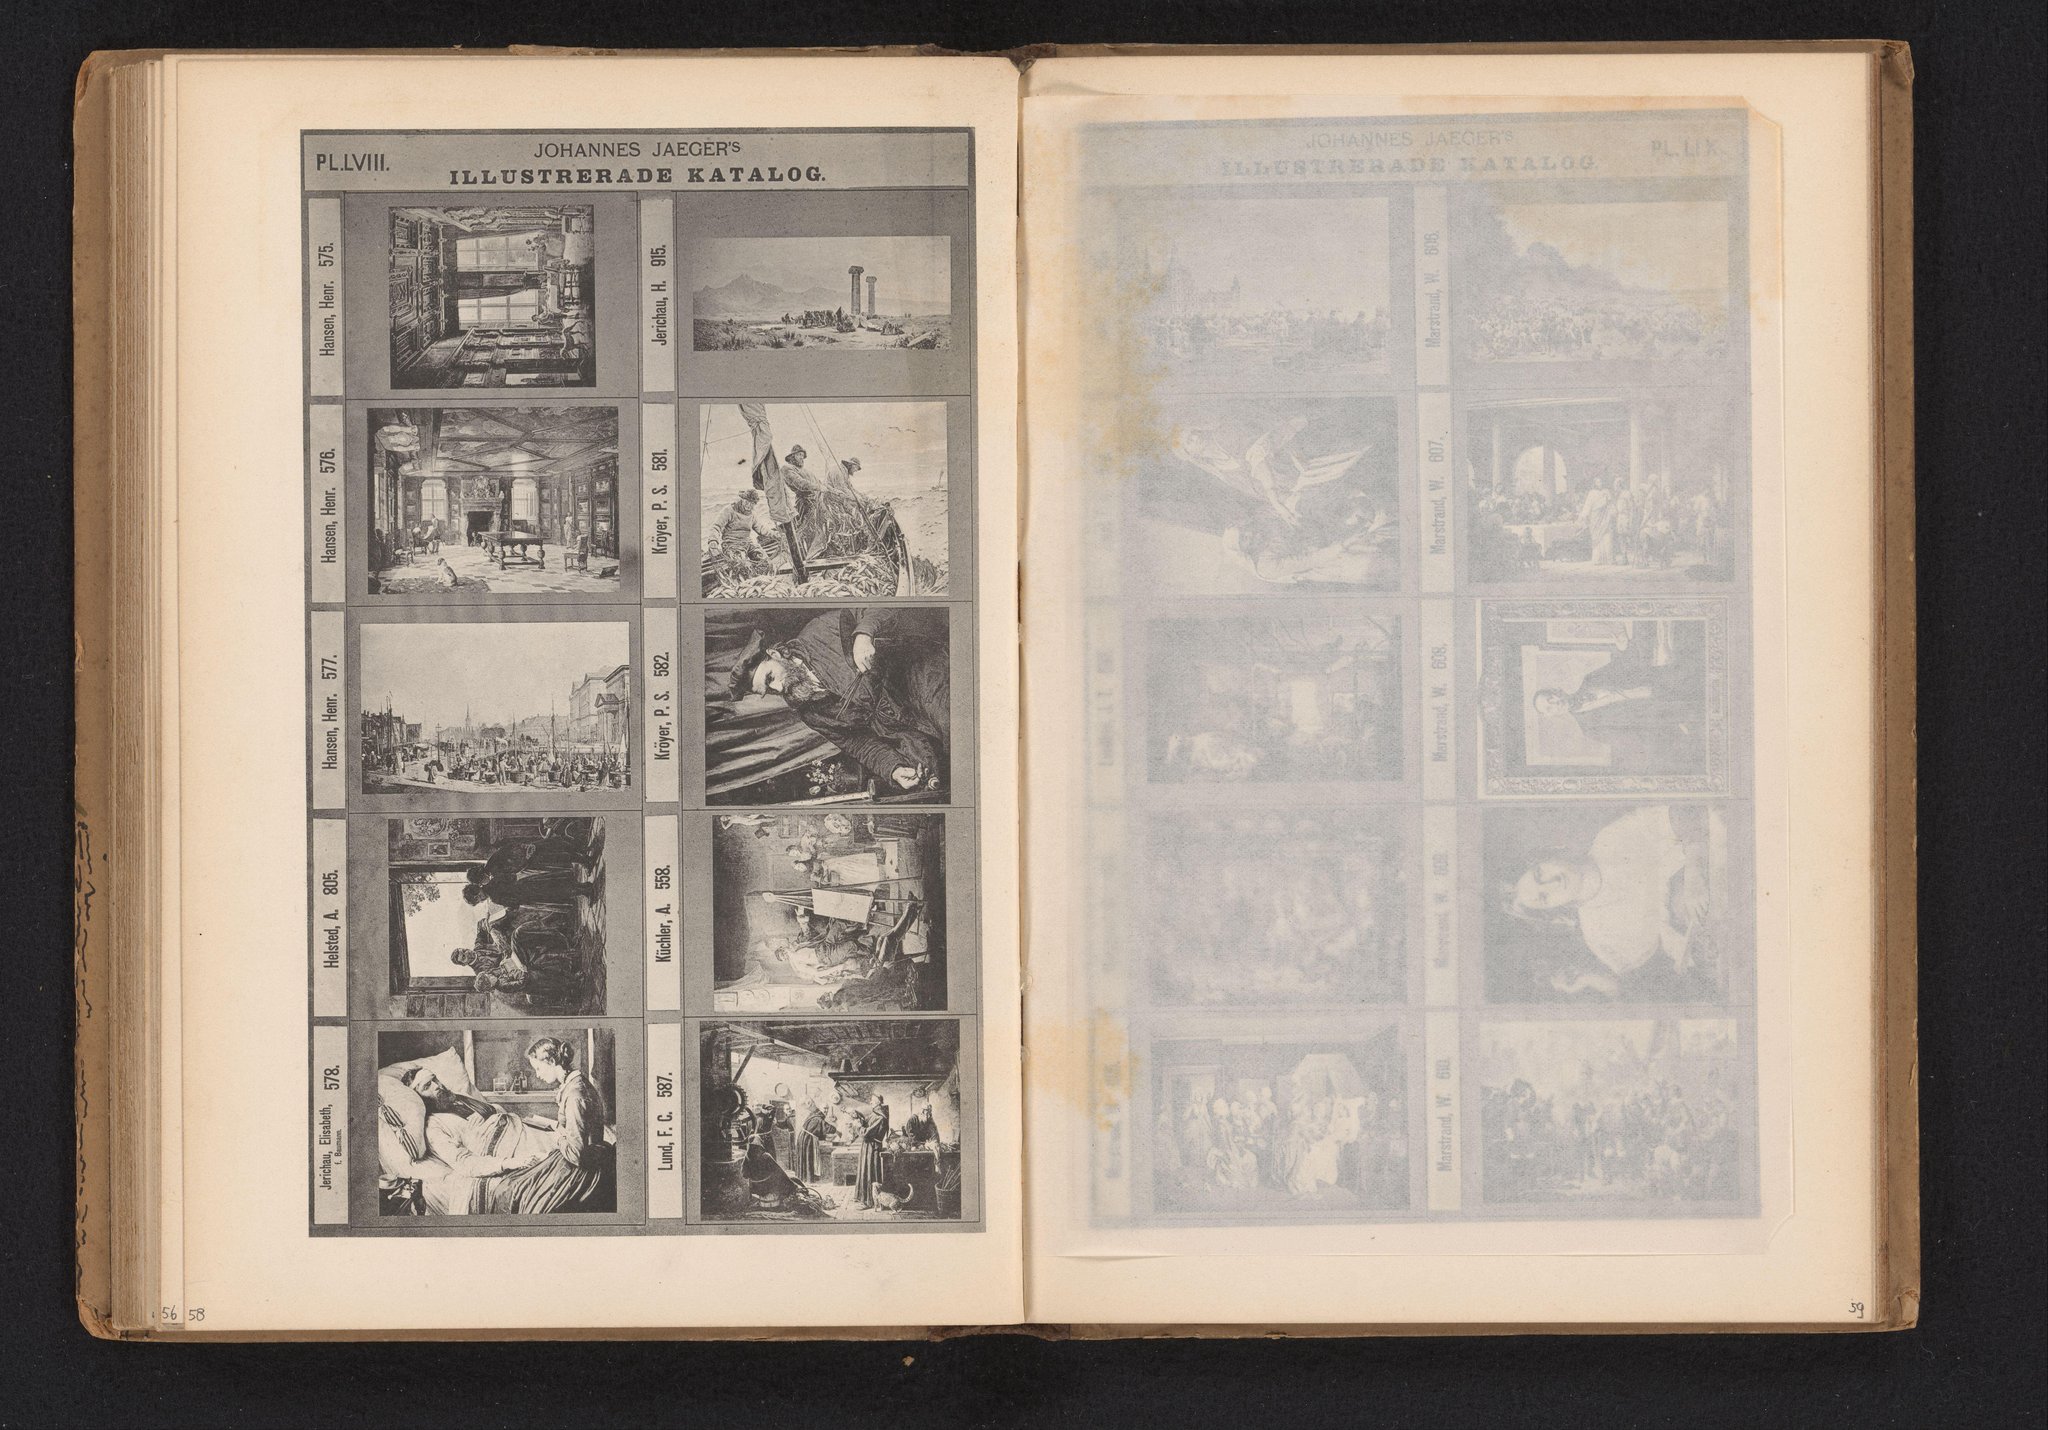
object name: page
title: Fotoreproductie van tien schilderijen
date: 1872-1882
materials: paper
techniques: photograph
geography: stockholm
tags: picture, painting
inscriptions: number: ‘PL. LVIII.’